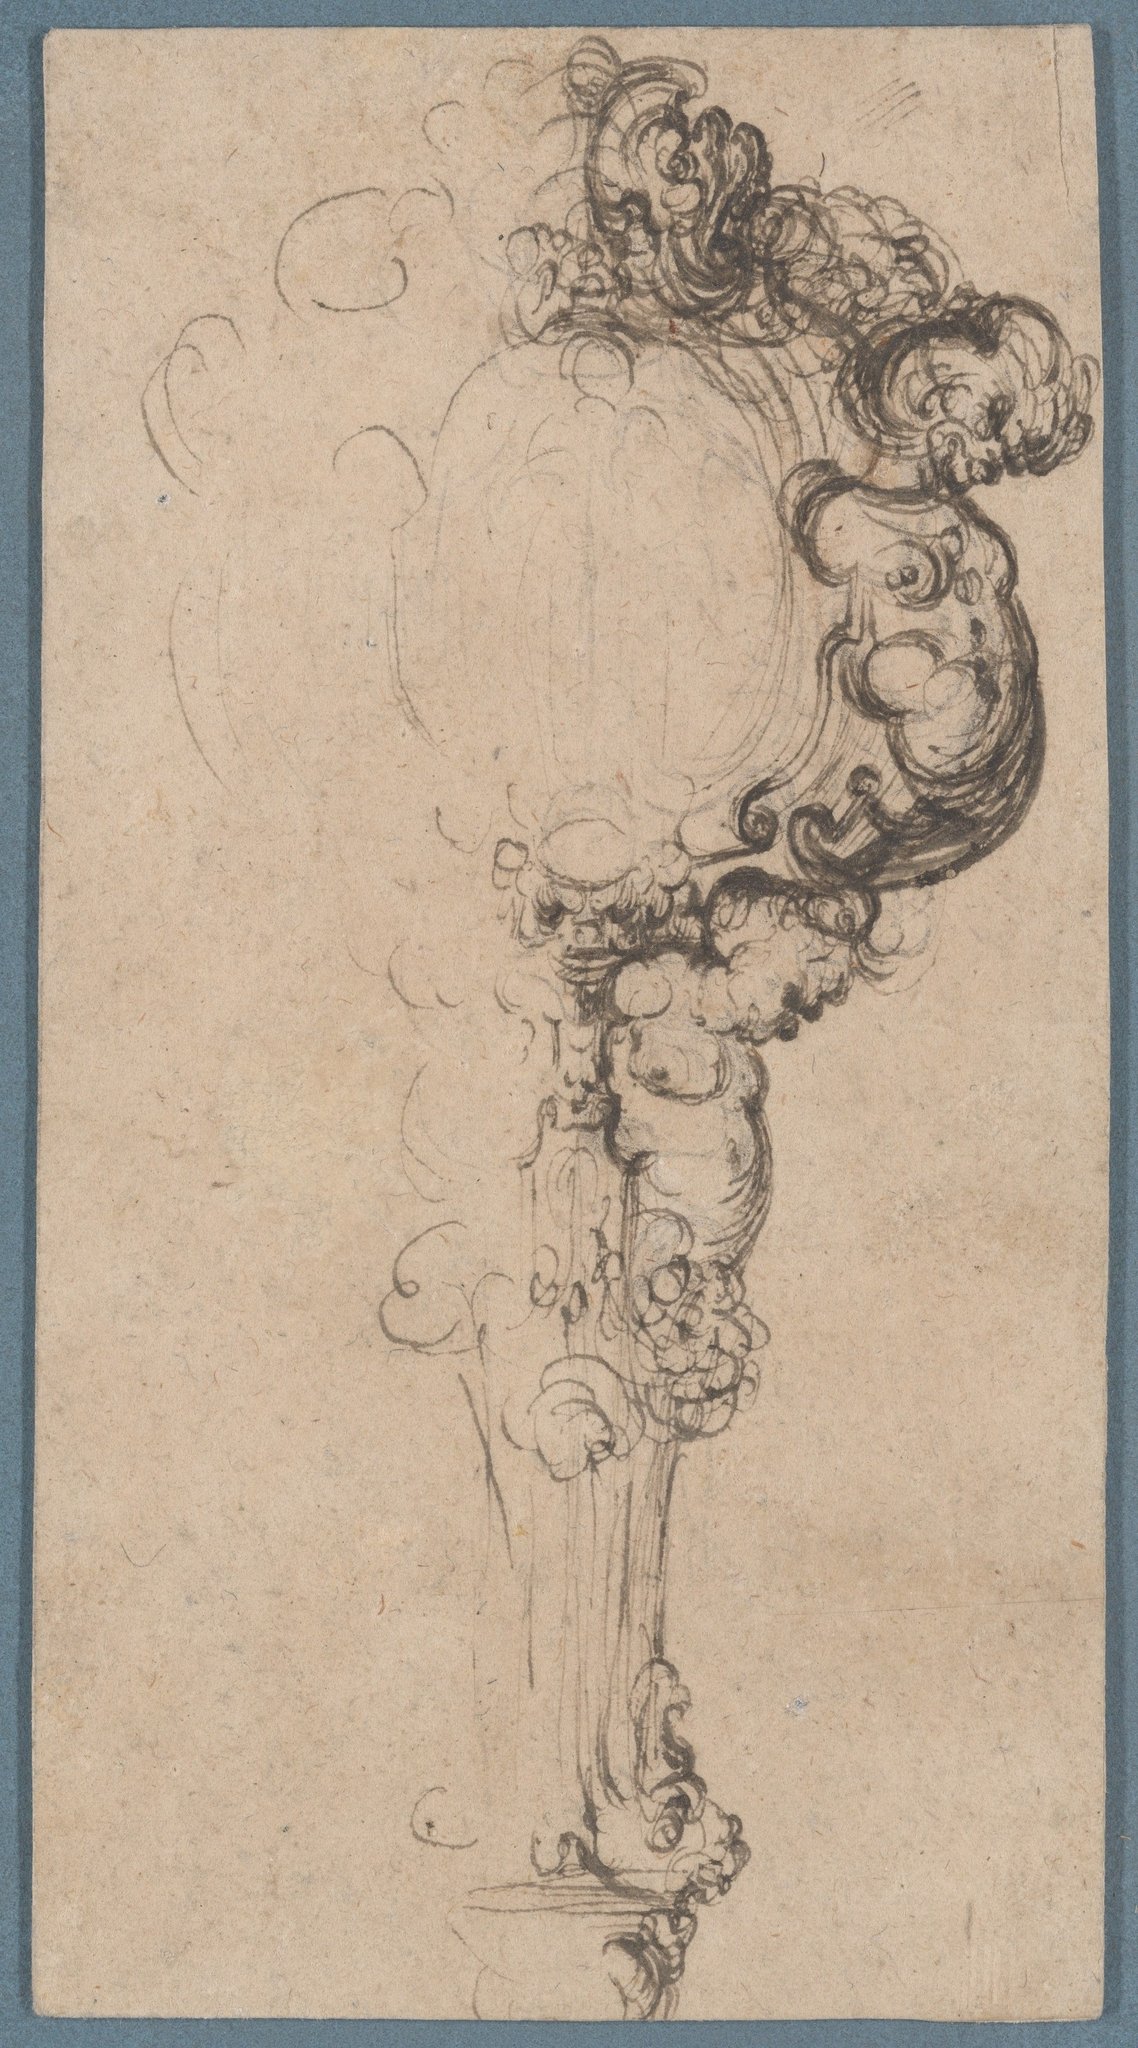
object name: drawing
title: Design for a Hand Mirror or Fan Handle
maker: anonymous, italian, 18th century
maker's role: artist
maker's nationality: italian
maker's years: 1700-1800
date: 1650-1700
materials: ink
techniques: pen